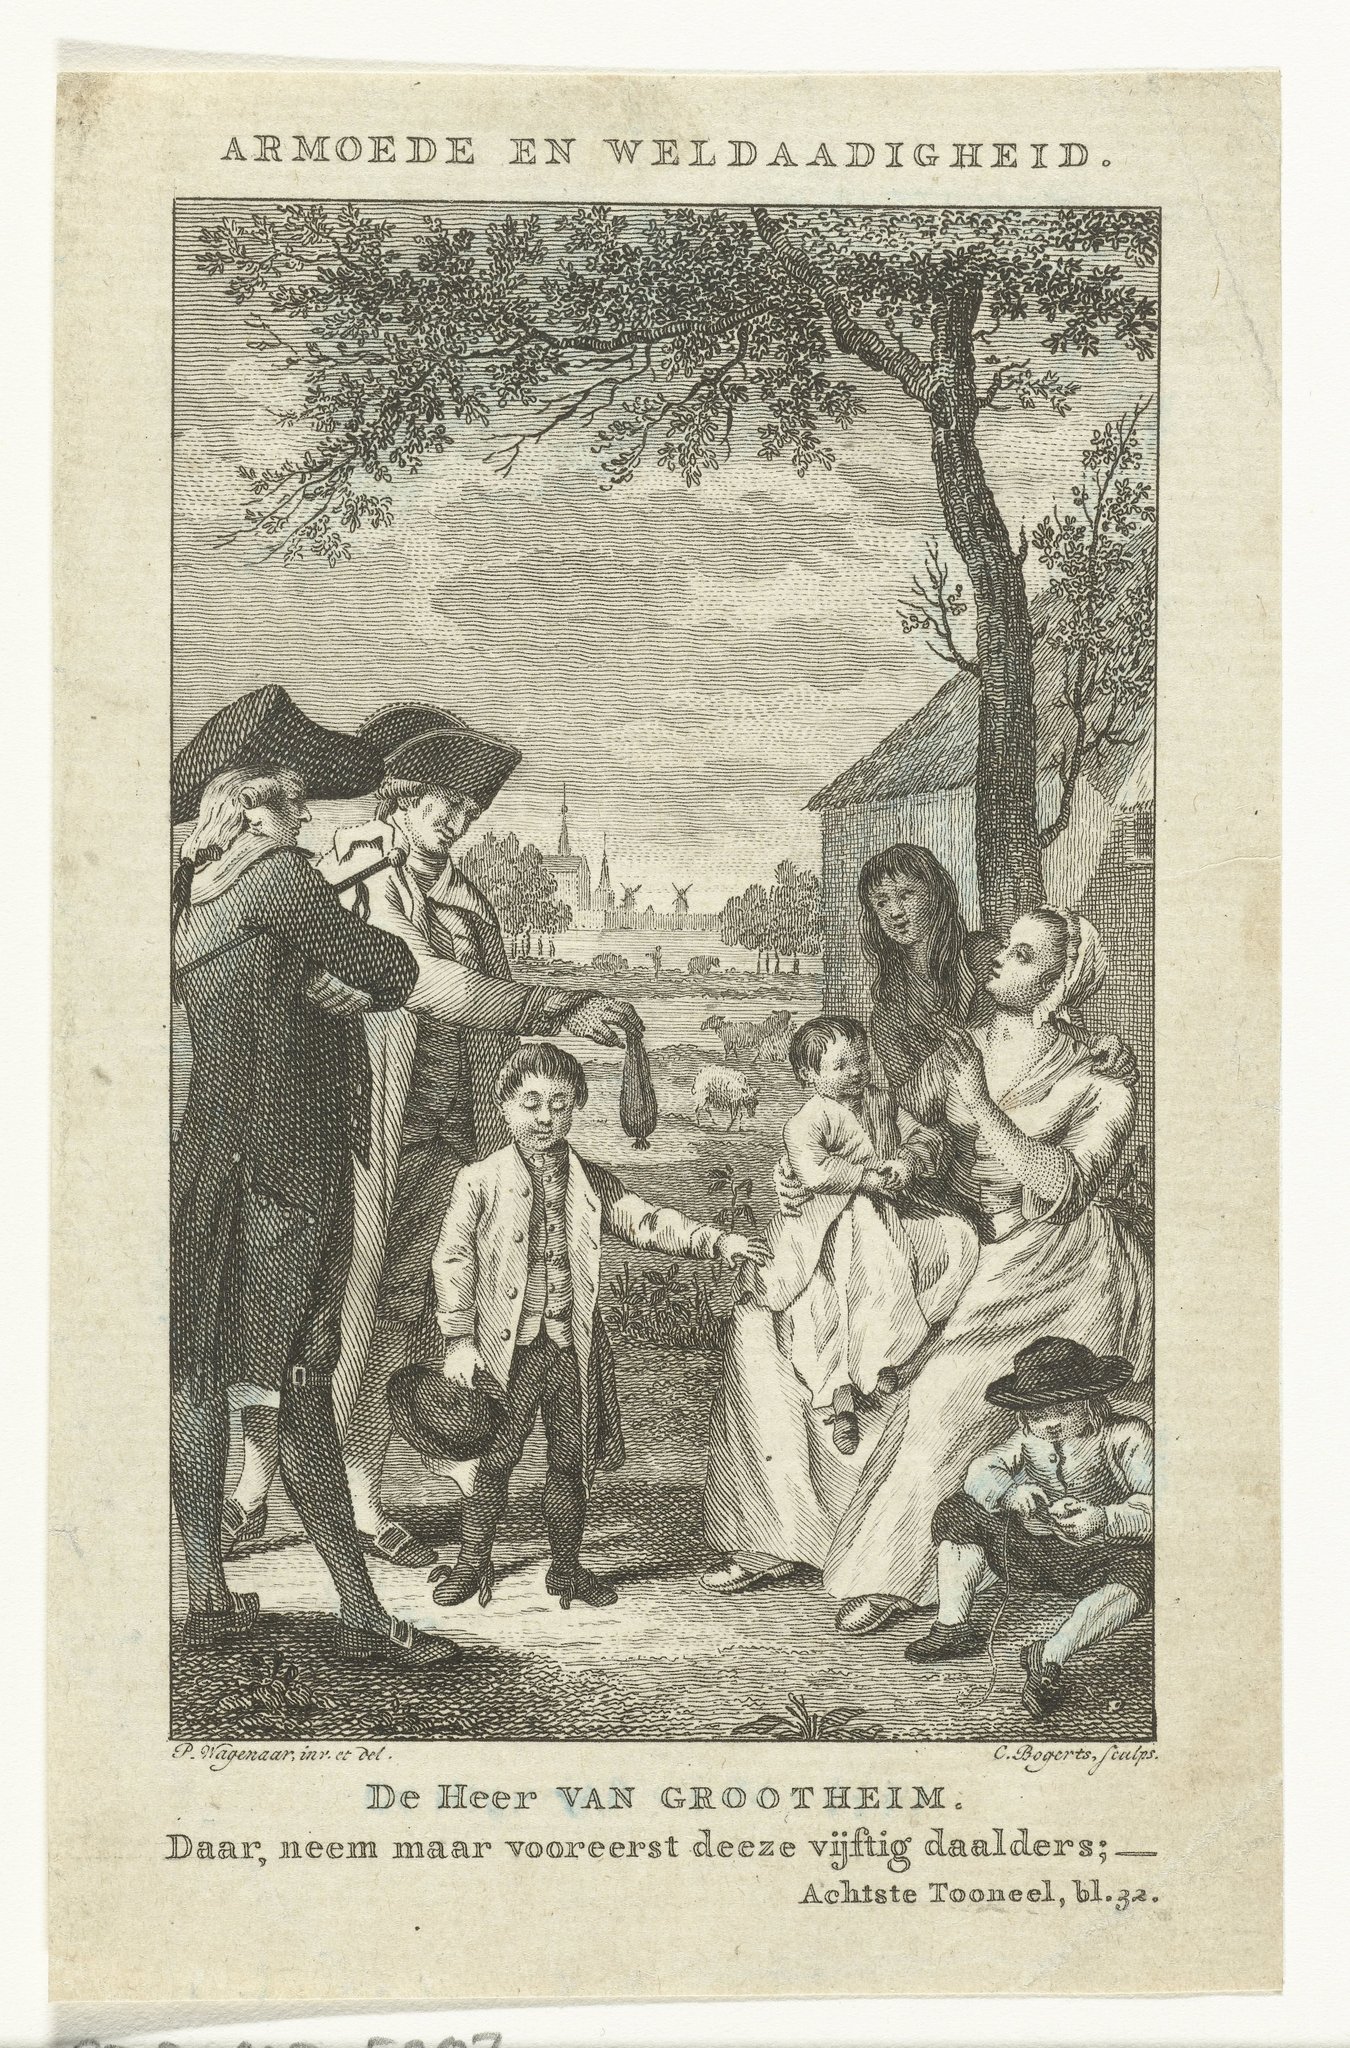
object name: print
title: De heer van Grootheim geeft geld aan de armen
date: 1760-1817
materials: paper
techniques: etching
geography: amsterdam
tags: giving alms or other charity, e.g.: handing out food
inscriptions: collector's mark: Lugt 2228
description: Een moeder met drie kinderen zit voor haar huis. Twee rijke mannen met een jongetje komen langs en geven de vrouw geld. Illustratie voor het achtste toneel van een toneelstuk.